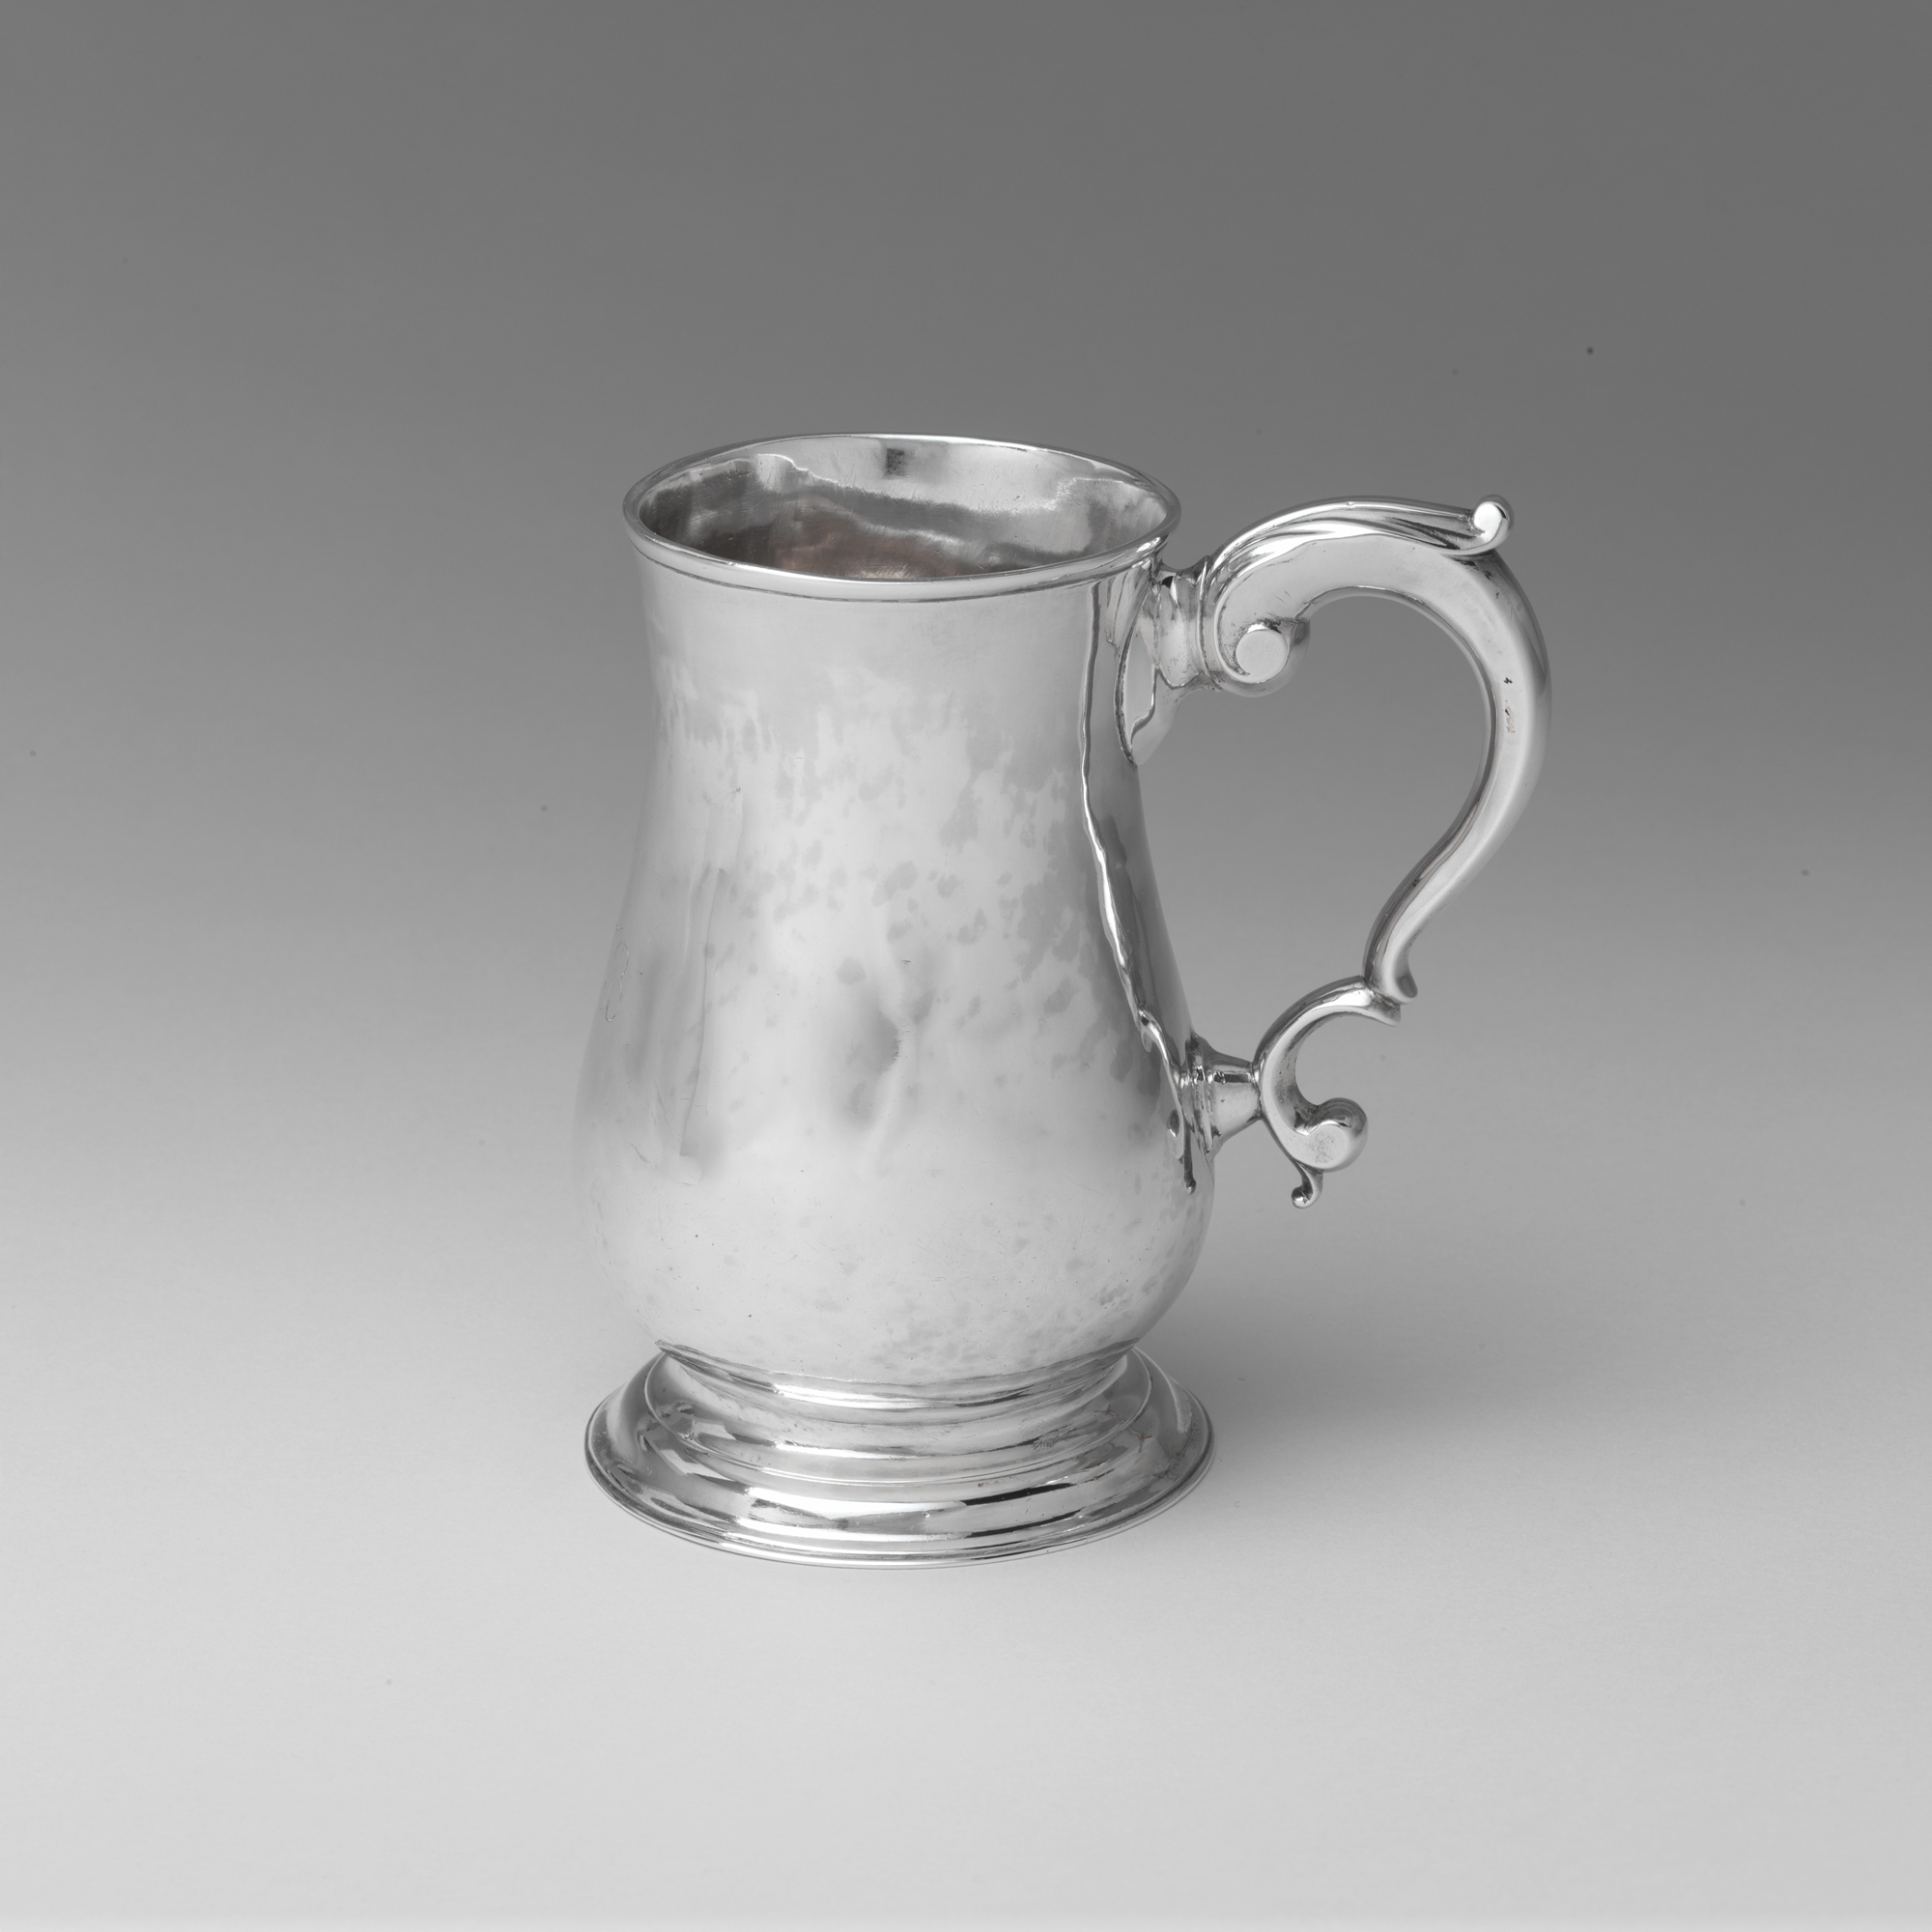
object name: cann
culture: american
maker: s. mars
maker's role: maker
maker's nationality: american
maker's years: 1720-1820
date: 1770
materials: silver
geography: united states